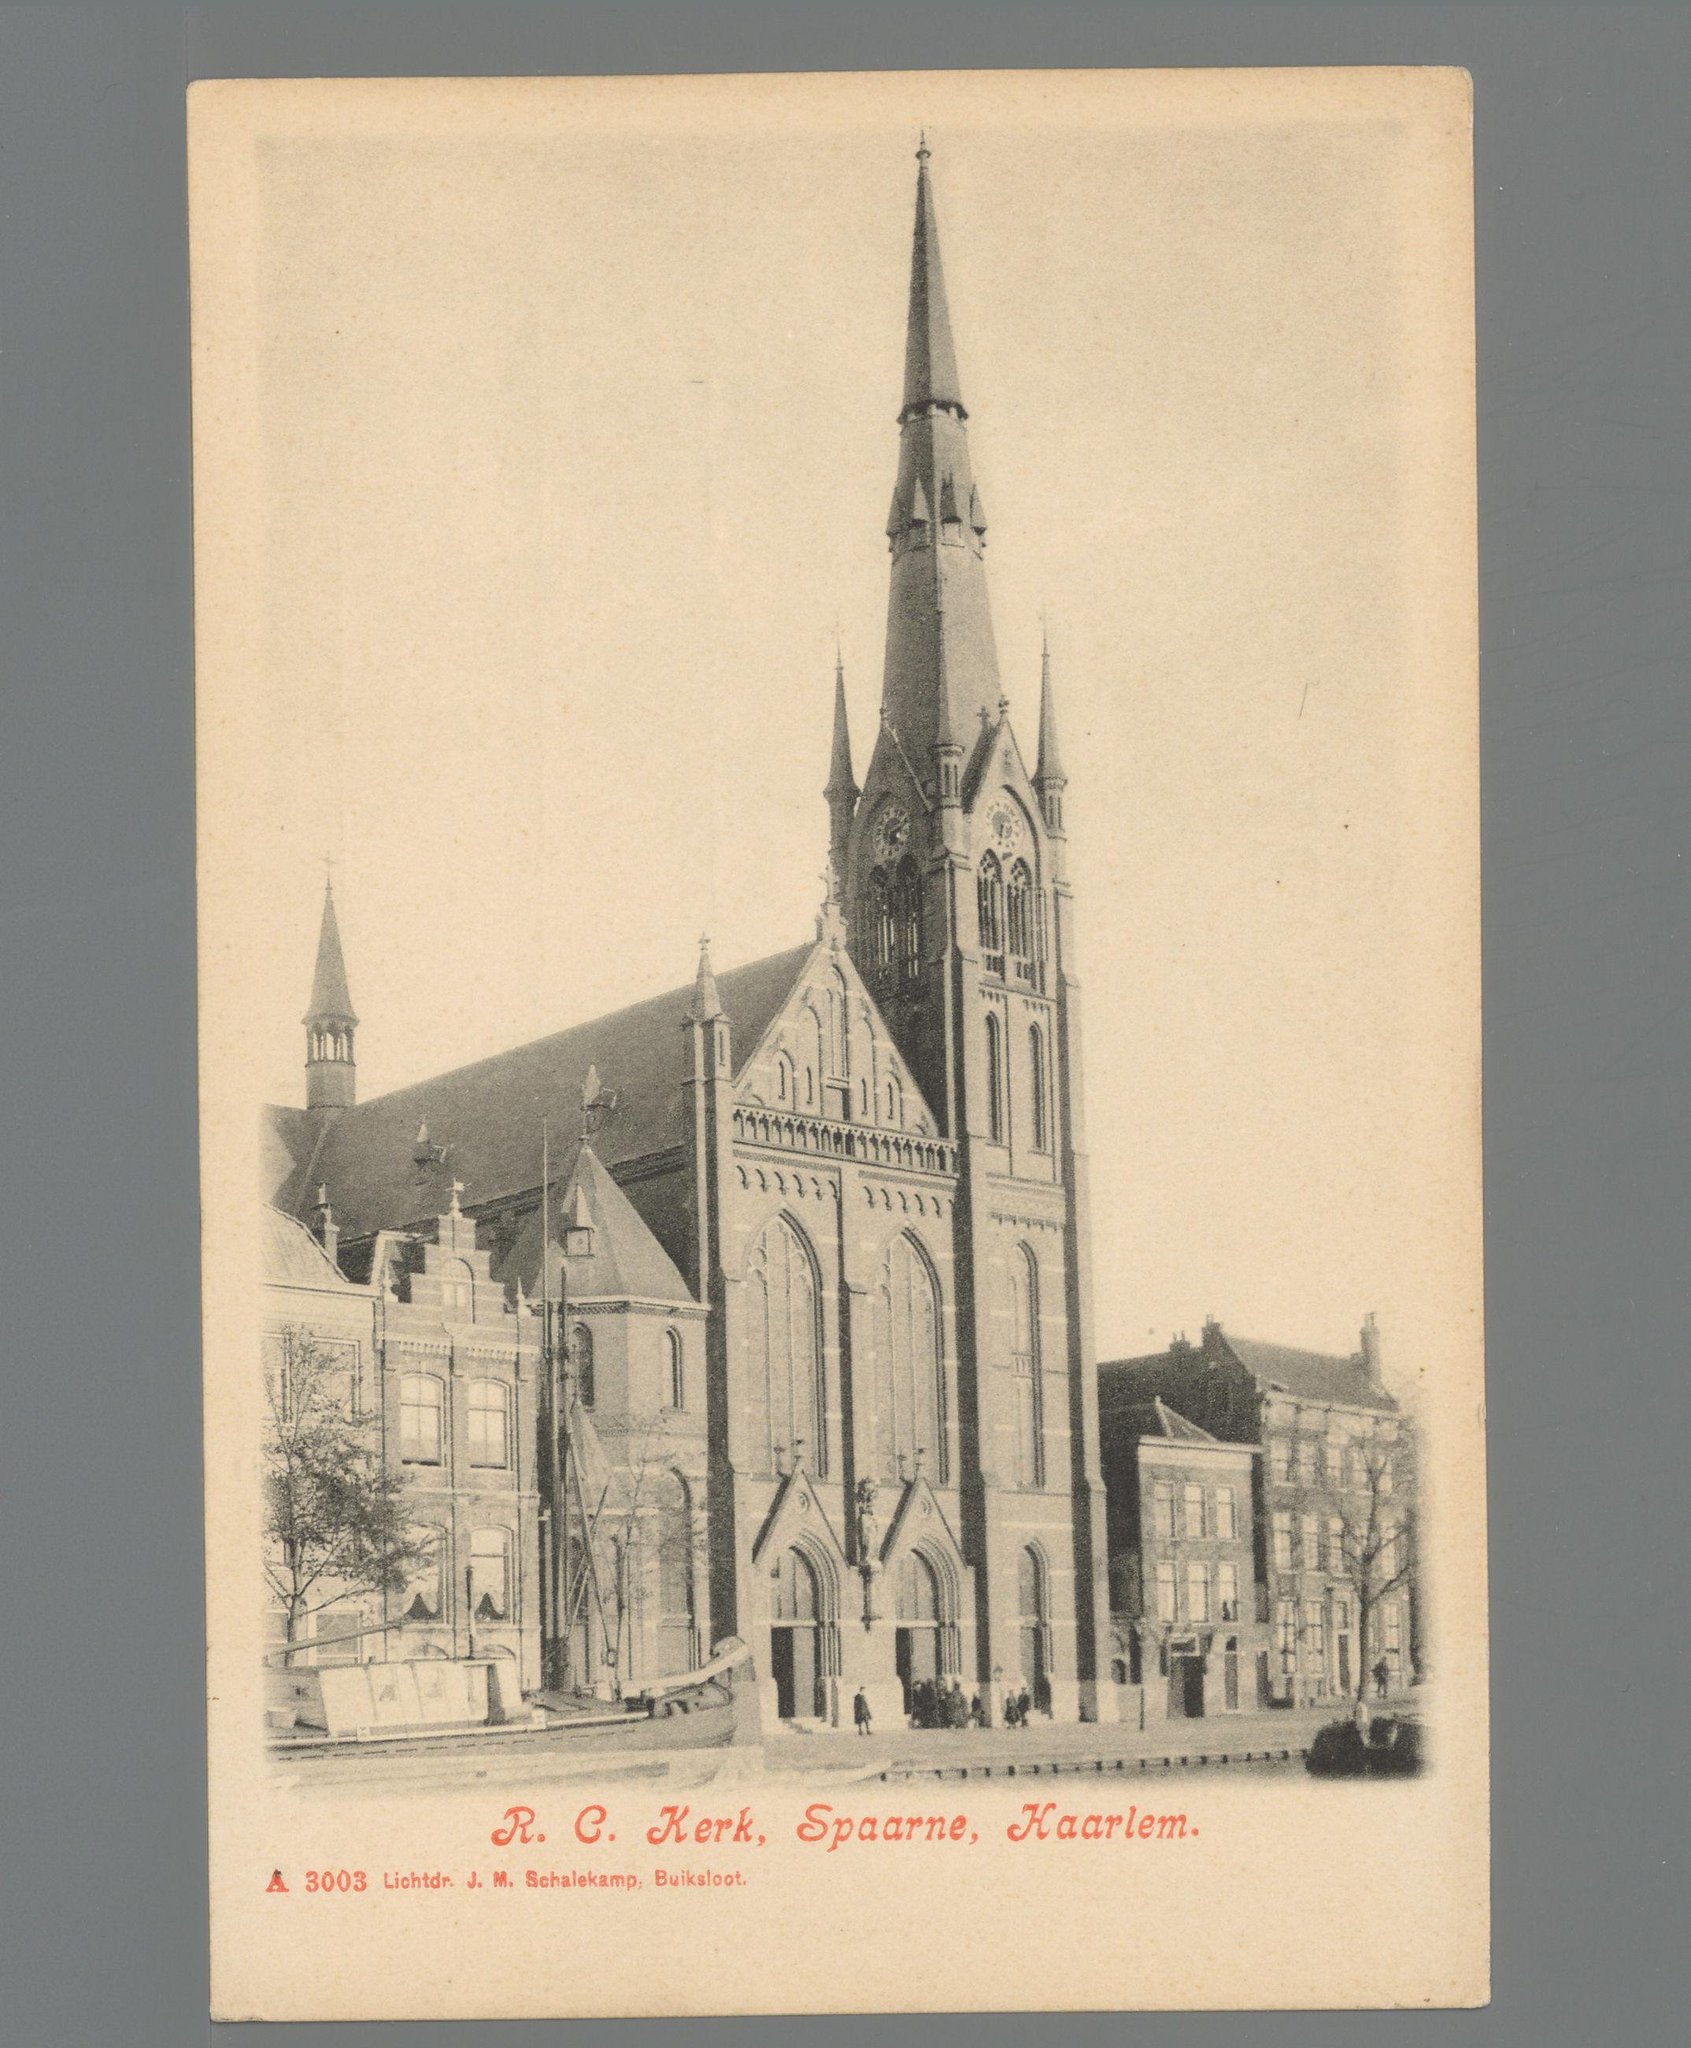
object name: ansichtkaart, prentbriefkaart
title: R.C. Kerk, Spaarne, Haarlem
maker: johan marinus schalekamp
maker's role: publisher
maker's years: 1844-1912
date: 1906-1926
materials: cardboard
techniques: photograph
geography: buiksloot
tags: church (exterior), haarlem